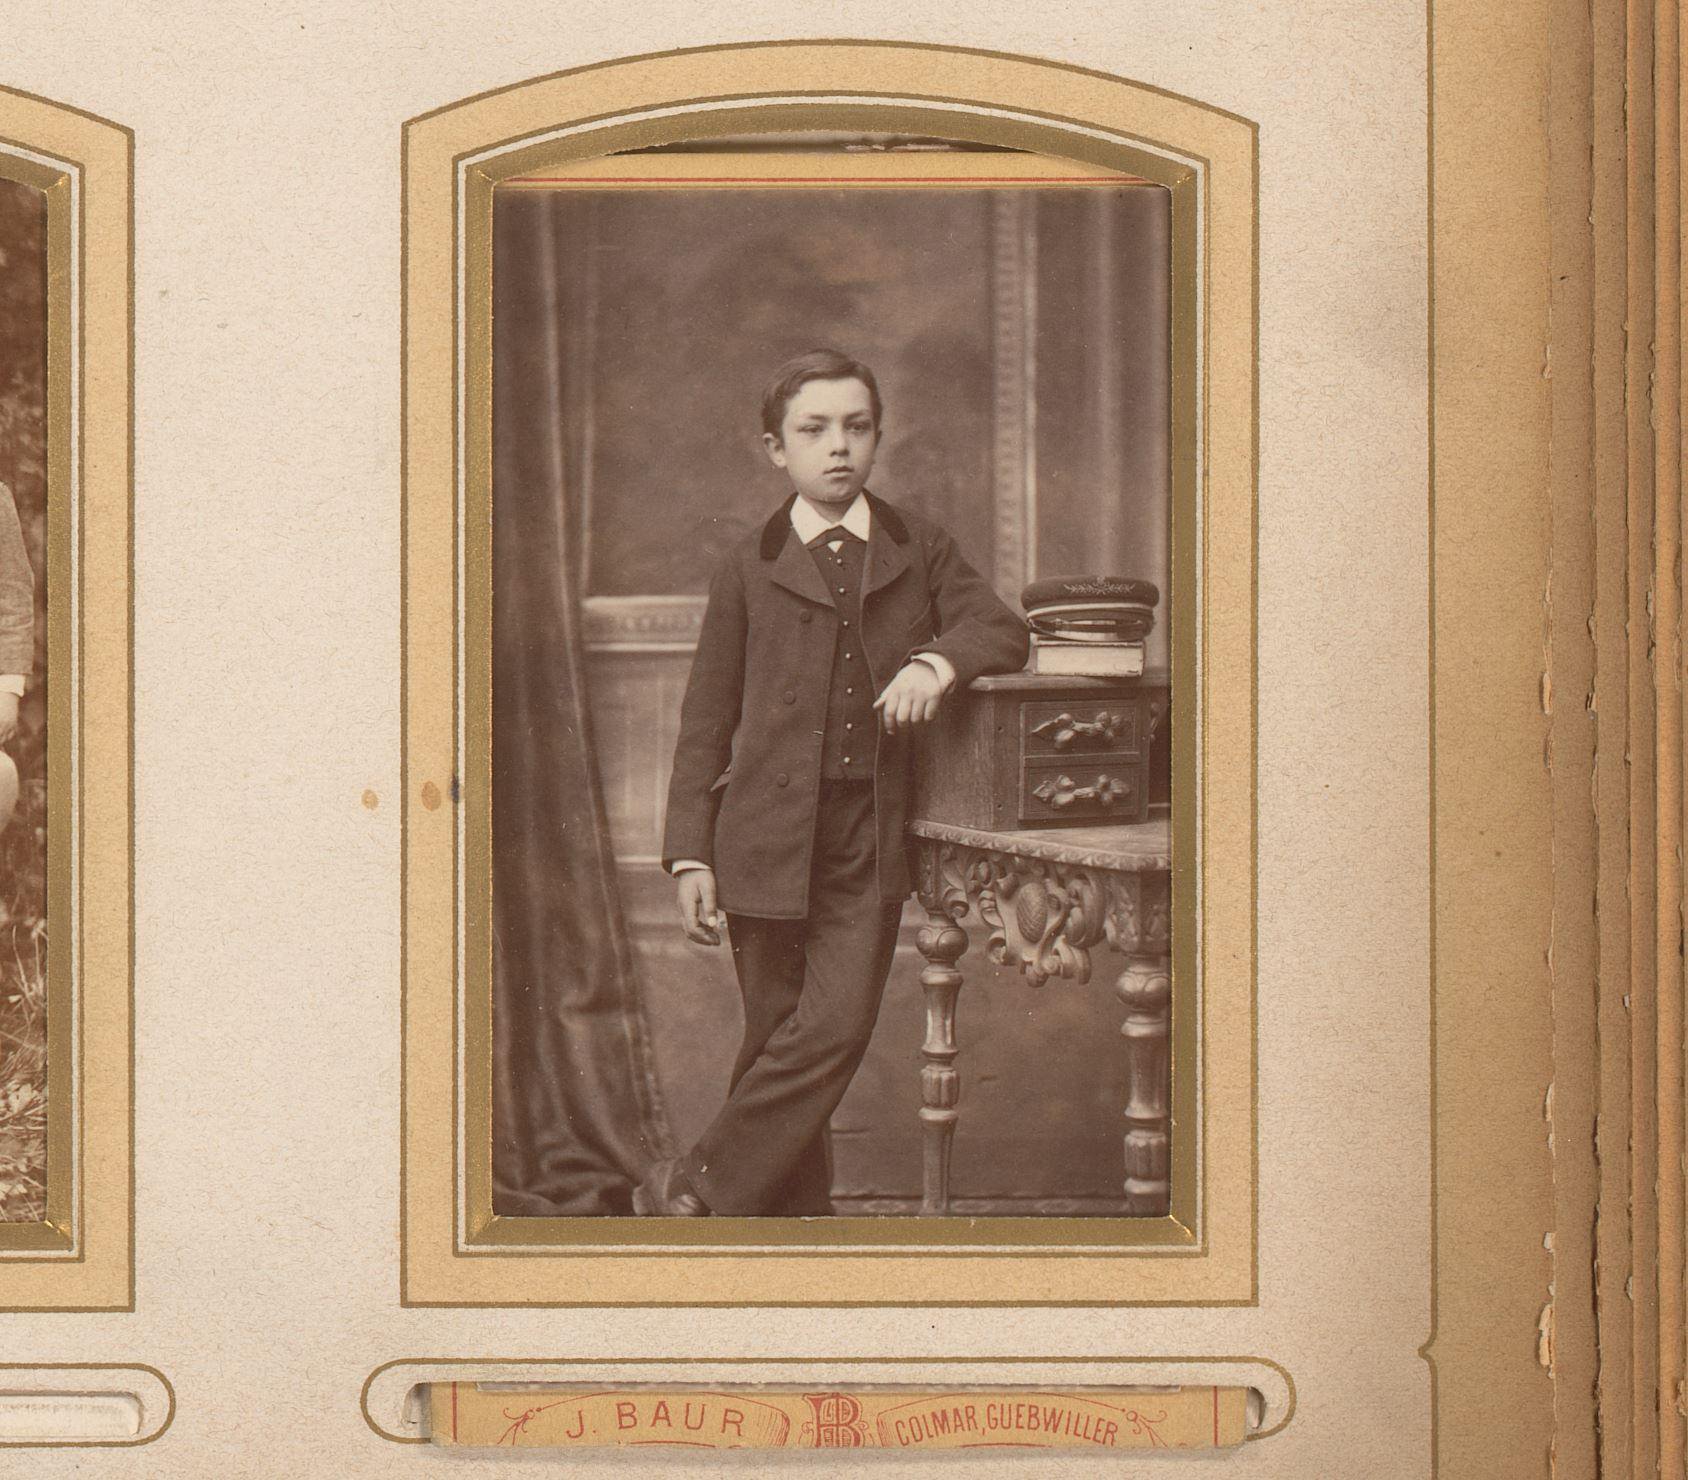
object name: photograph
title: Portret van een jongen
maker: j. baur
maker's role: fotograaf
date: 1860-1900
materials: cardboard, photographic support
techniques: albumen print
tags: boy (child between toddler and youth), historical persons